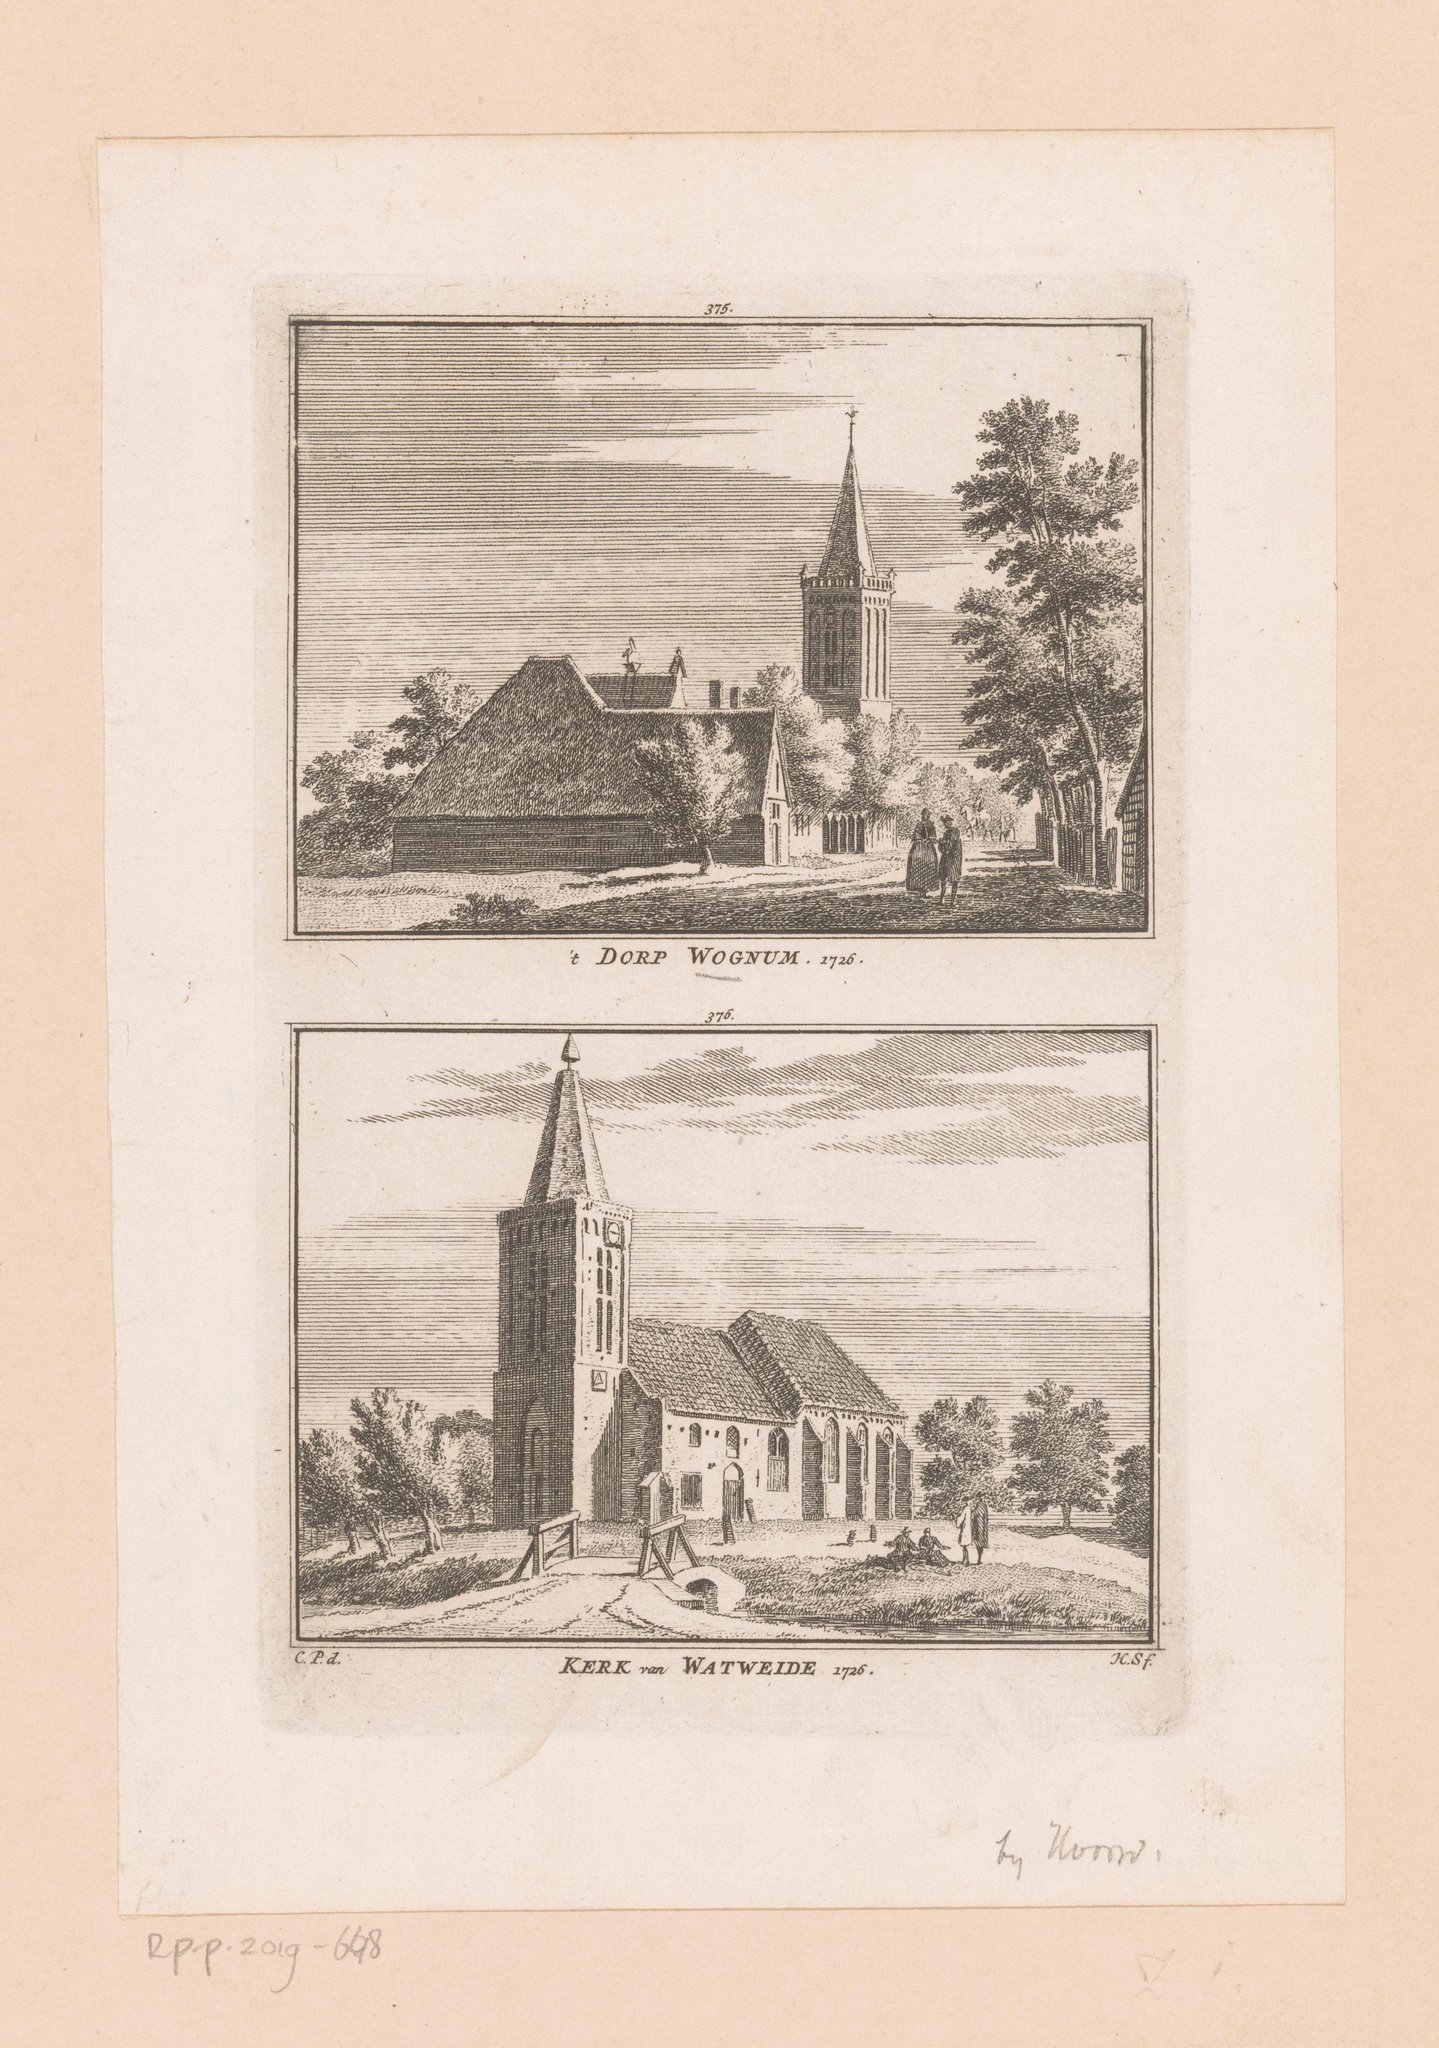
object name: print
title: Kerk van Watweide, 1726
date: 1745-1774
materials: paper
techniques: etching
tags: the christian churches, village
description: Prent verschenen in: Het verheerlykt Nederland of kabinet van hedendaagsche gezigten. Amsterdam: Isaac Tirion, 1745-1774.